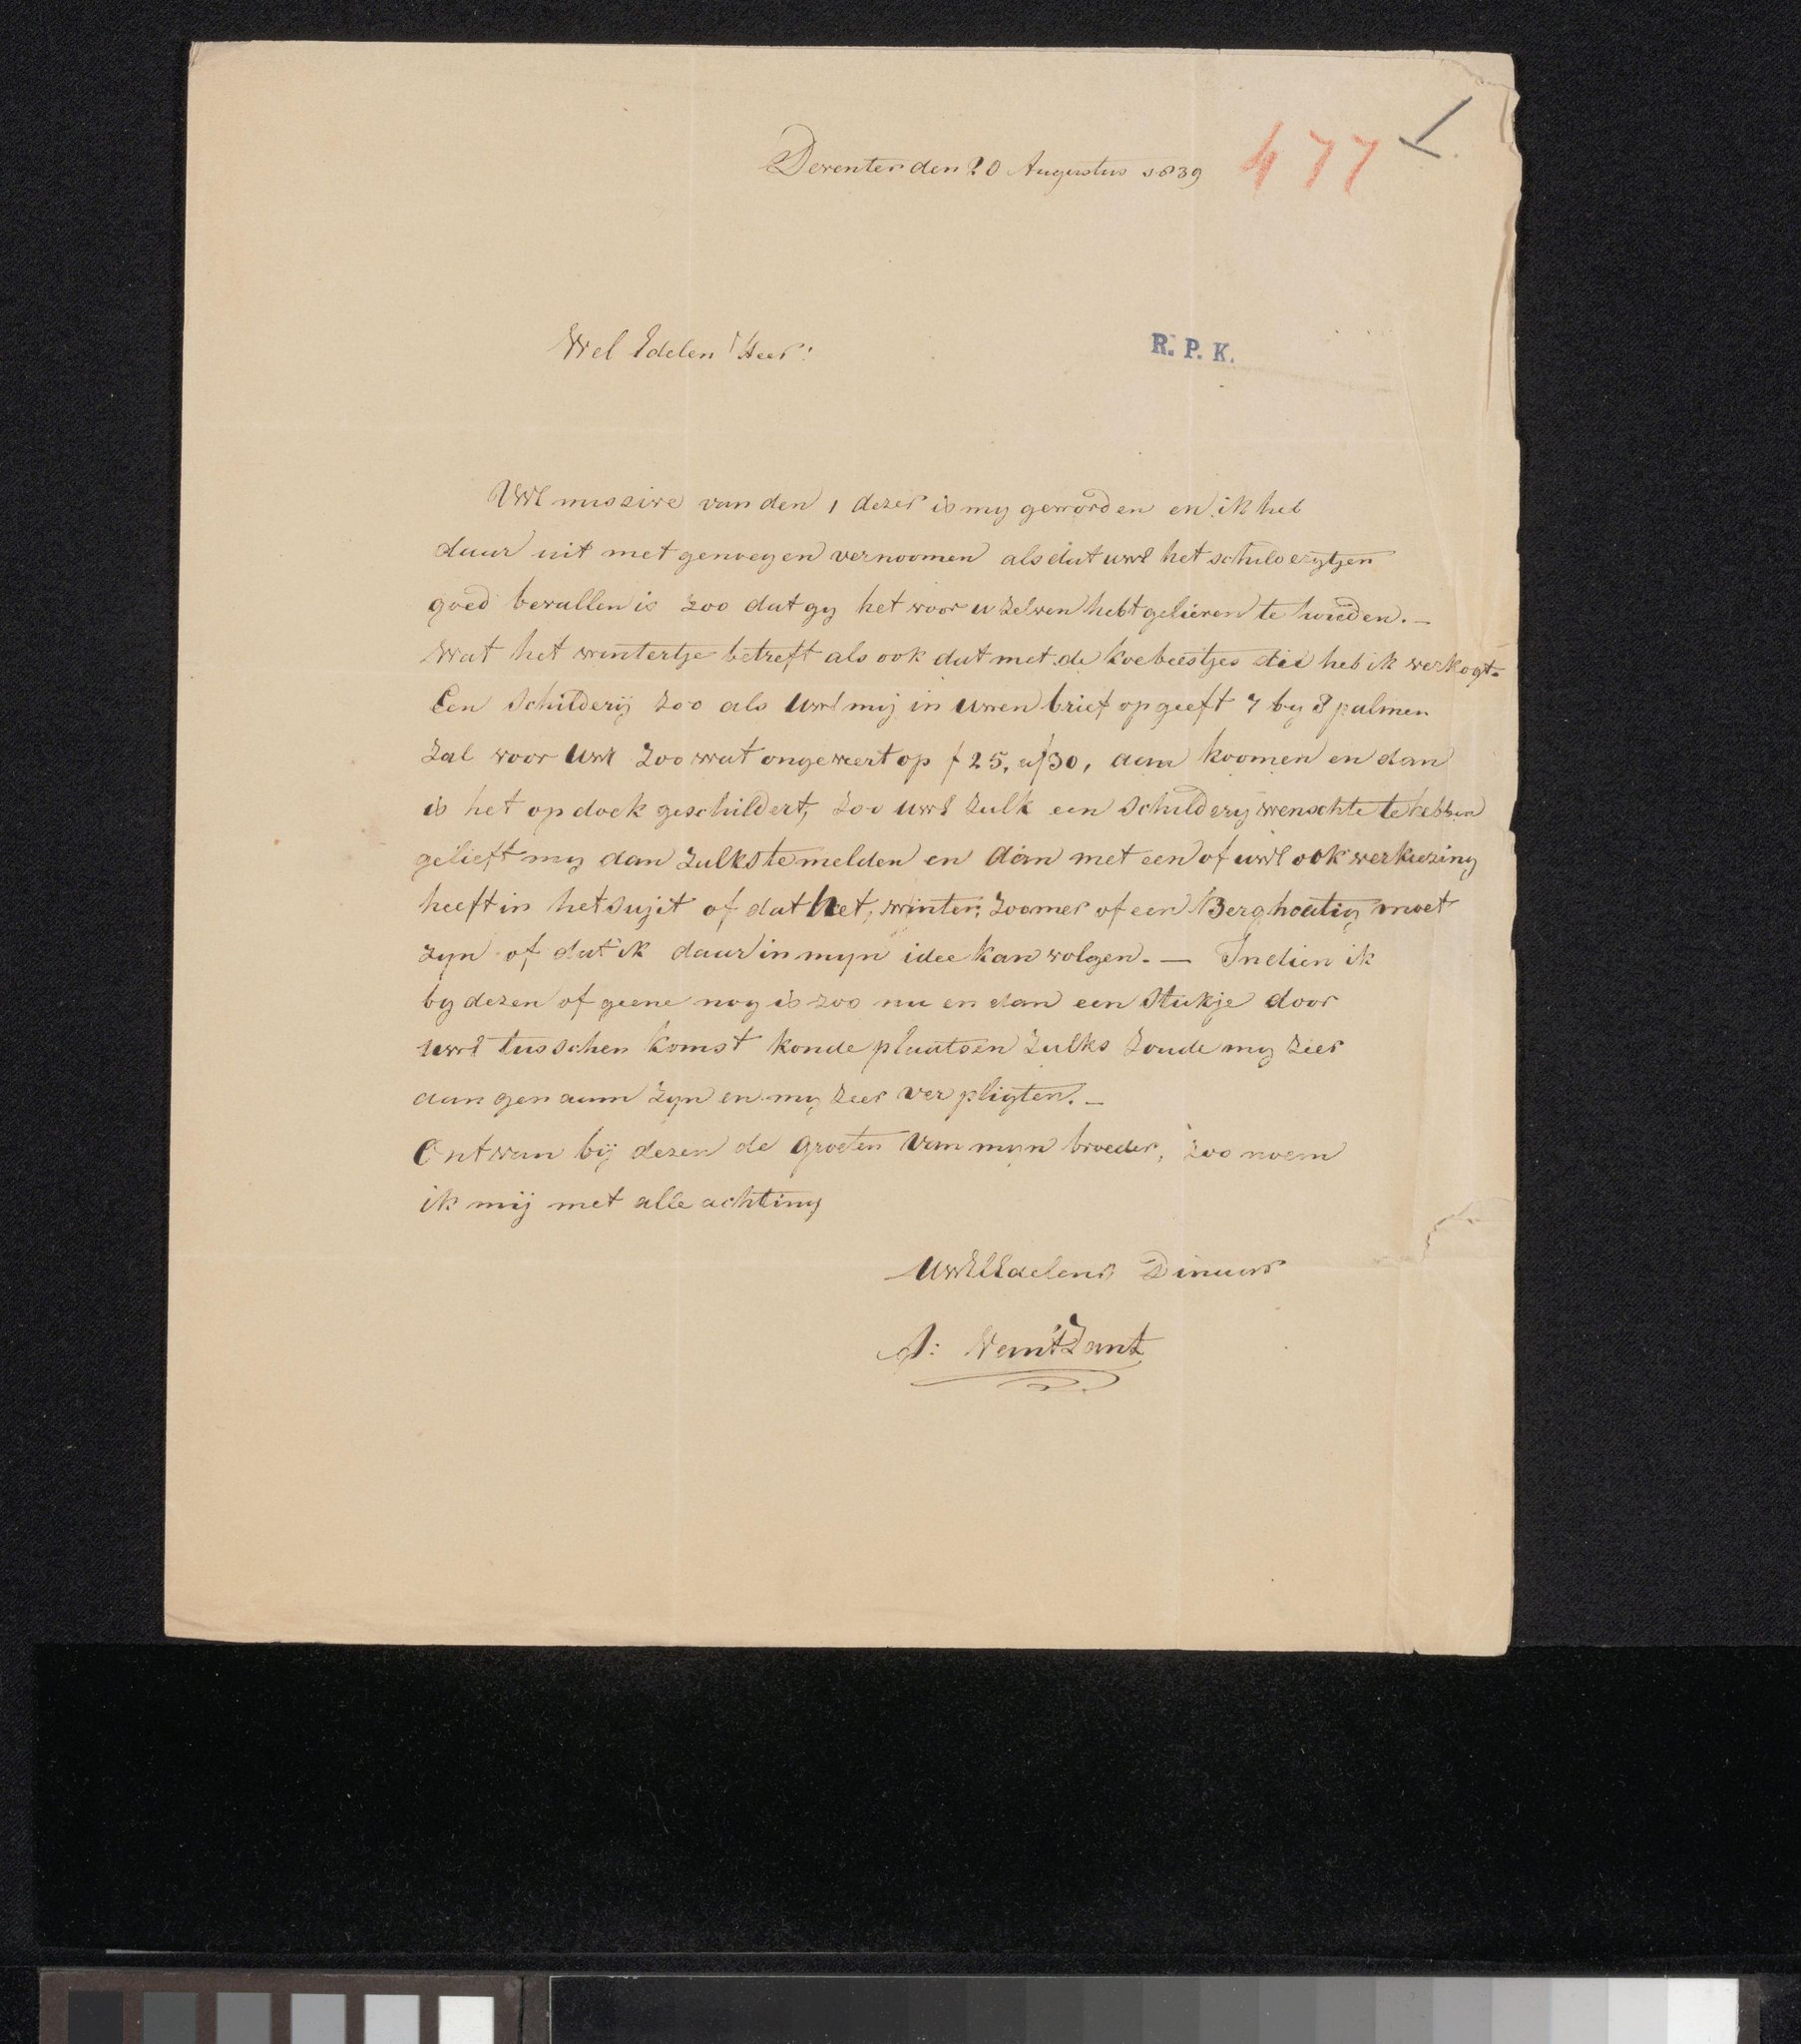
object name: letter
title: Brief aan Christiaan Kramm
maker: arnoldus antonius christianus van t zant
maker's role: print maker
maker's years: 1815-1889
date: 1839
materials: ink, paper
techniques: pen, writing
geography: deventer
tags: utrecht, draughtsman, christiaan kramm, painting (including book-illumination, miniature-painting), money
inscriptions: collector's mark: Lugt 2233